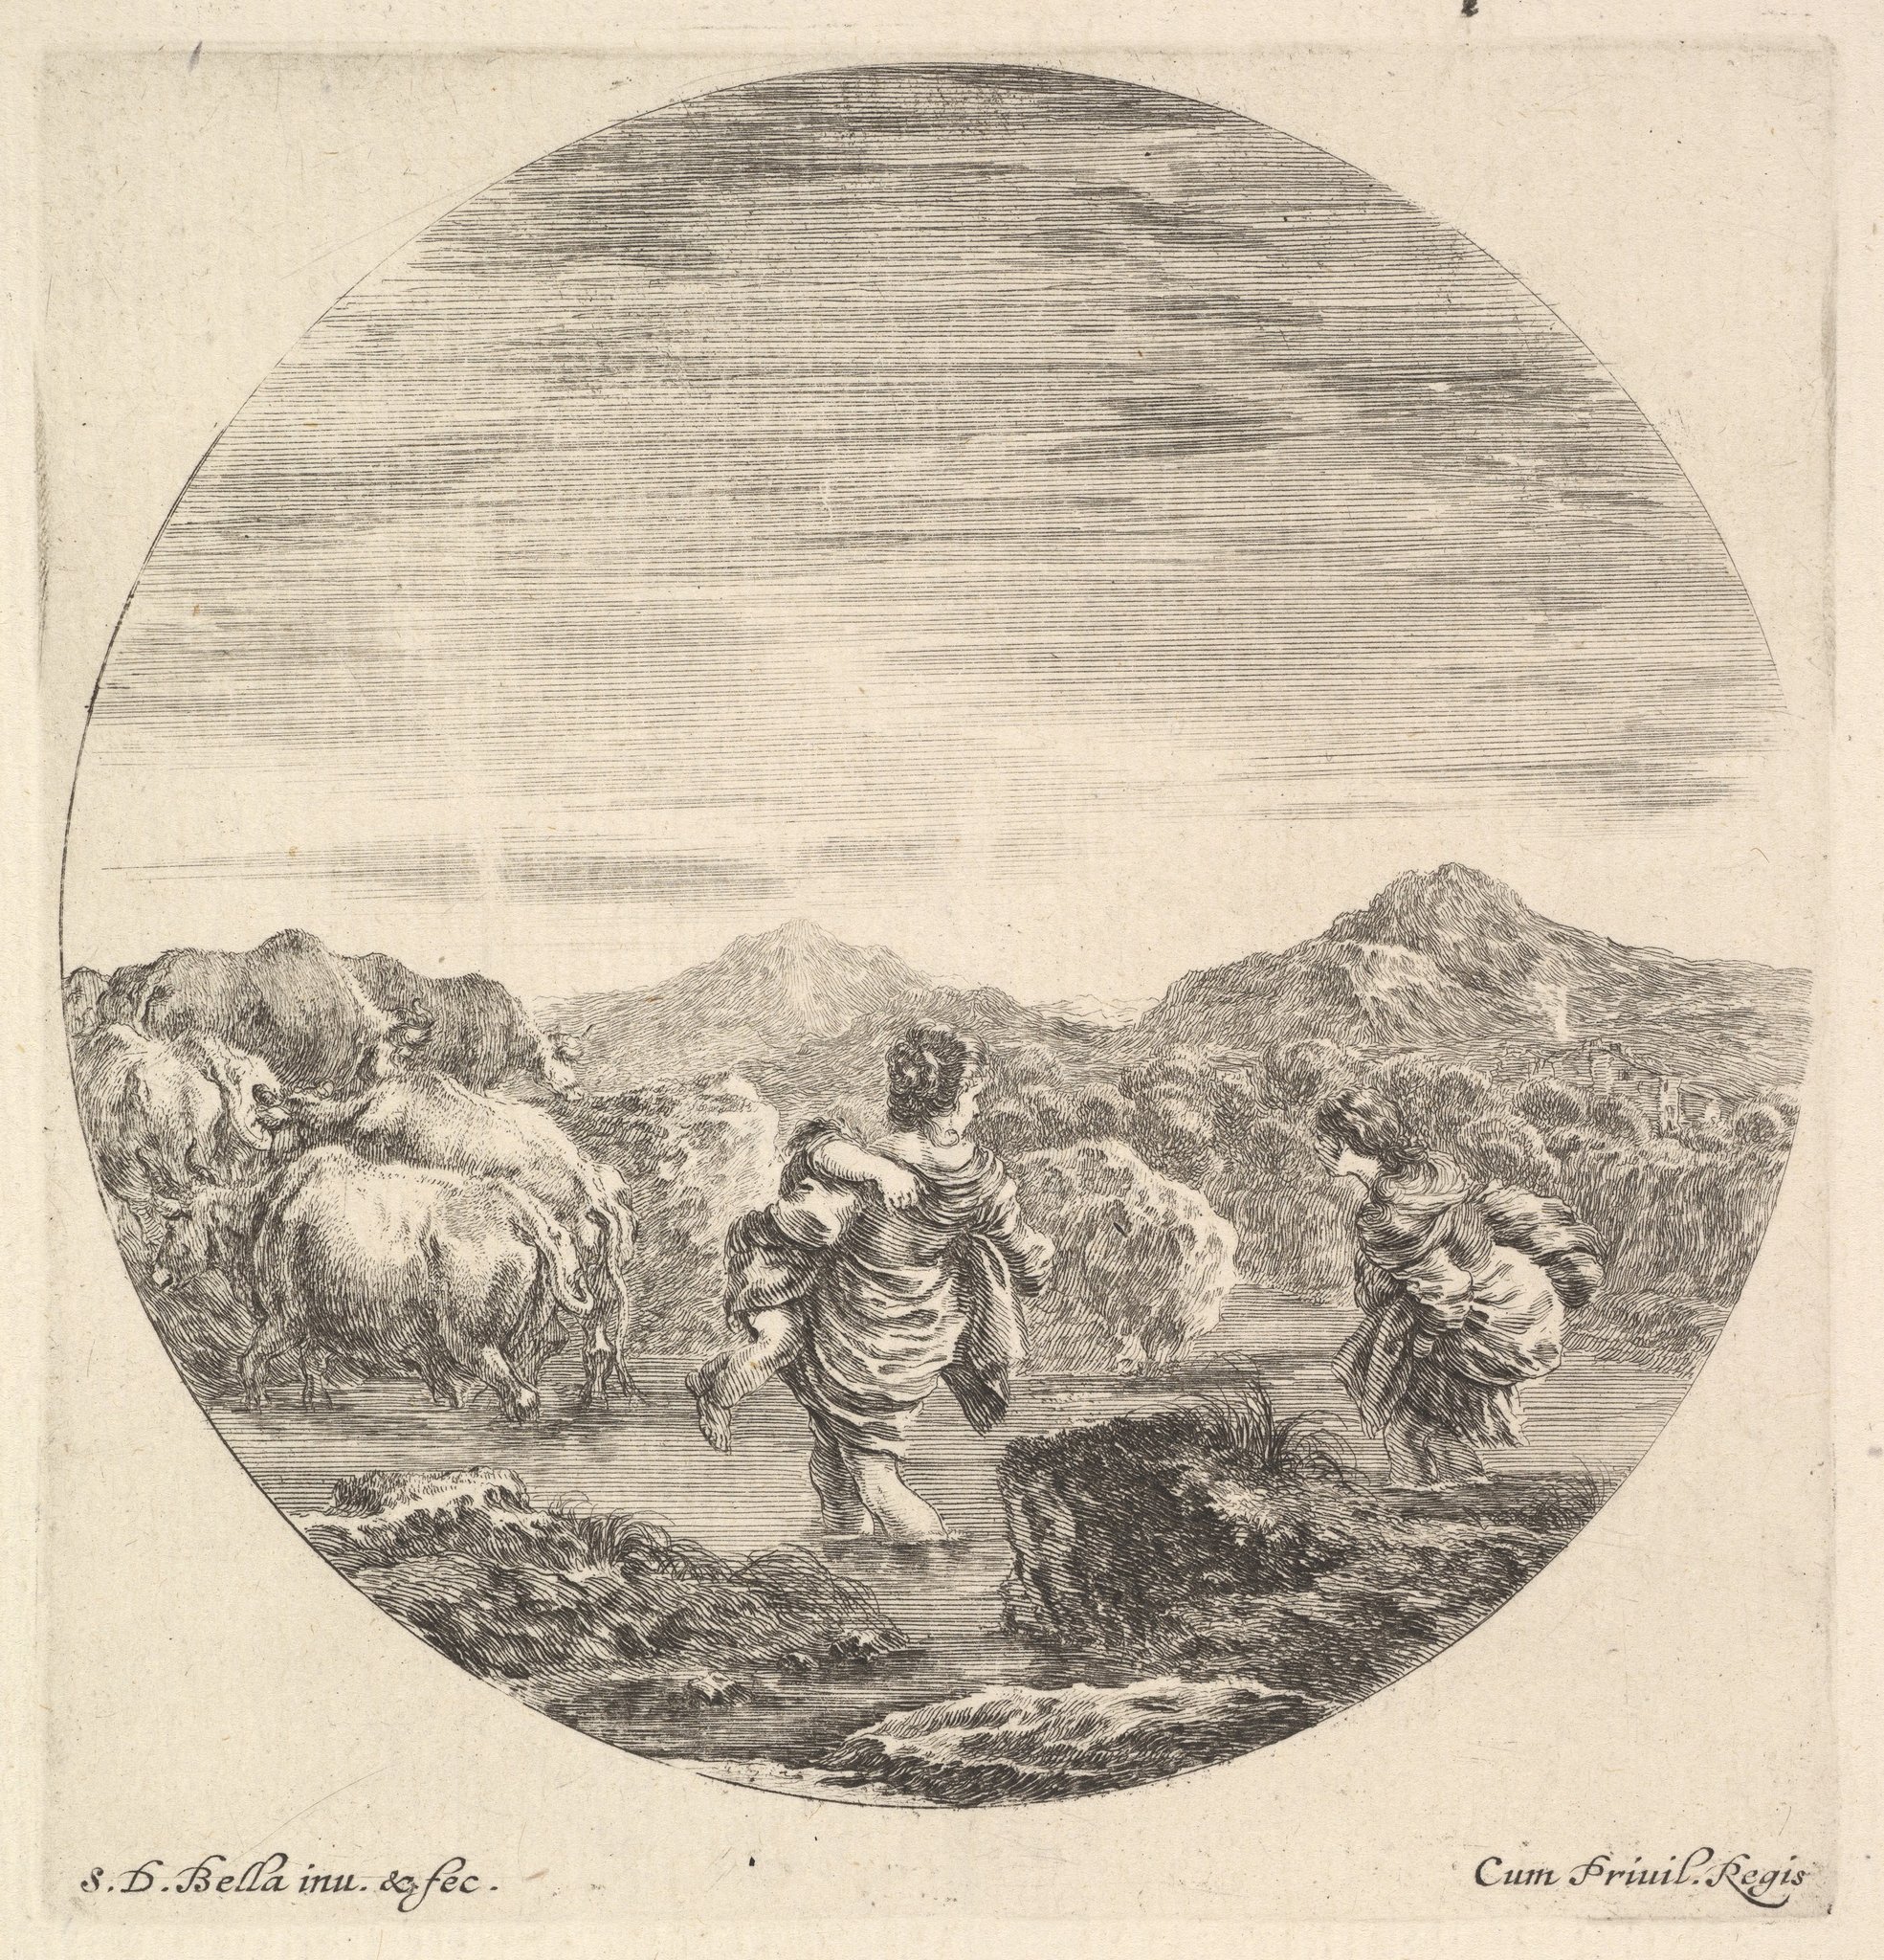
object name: print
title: A woman carrying a child in center, seen from behind, another woman to right, facing left, following a group of cows across a river, from "Six Animal Subjects" (Six Sujets d'Animaux)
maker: stefano della bella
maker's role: artist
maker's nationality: italian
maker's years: 1610-1664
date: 1643-1648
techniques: etching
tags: children,women,cows,rivers